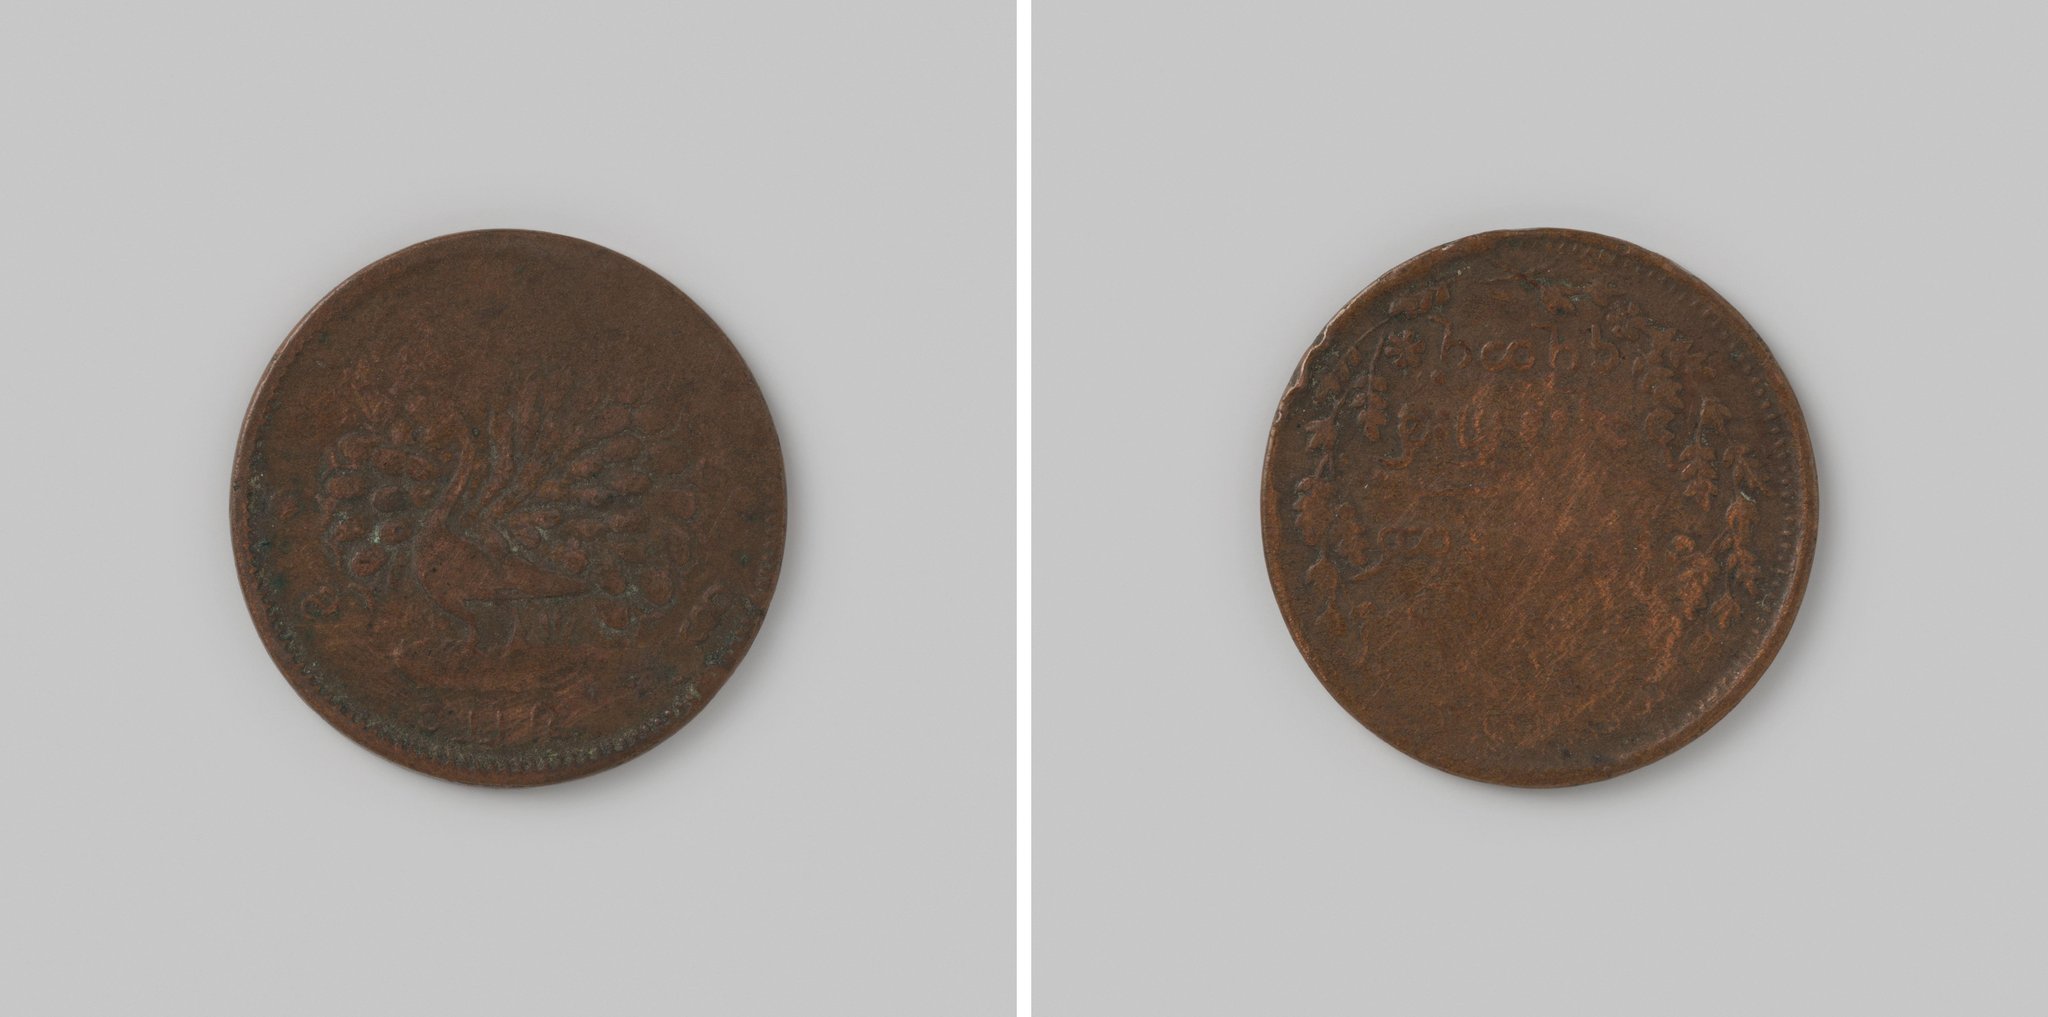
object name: coin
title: Birma, Mindon Min, 1/4 anna of 1/4 pe, 1227 [=1865]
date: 1865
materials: copper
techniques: striking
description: Koperen munt. Voorzijde: een pauw. Daaronder jaartal: 1227. Keerzijde: tussen twee gekruiste takken muntplaats-aanduiding [=Mandalay] in twee regels, waaronder waarde-aanduiding in twee regels. Gladde rand.